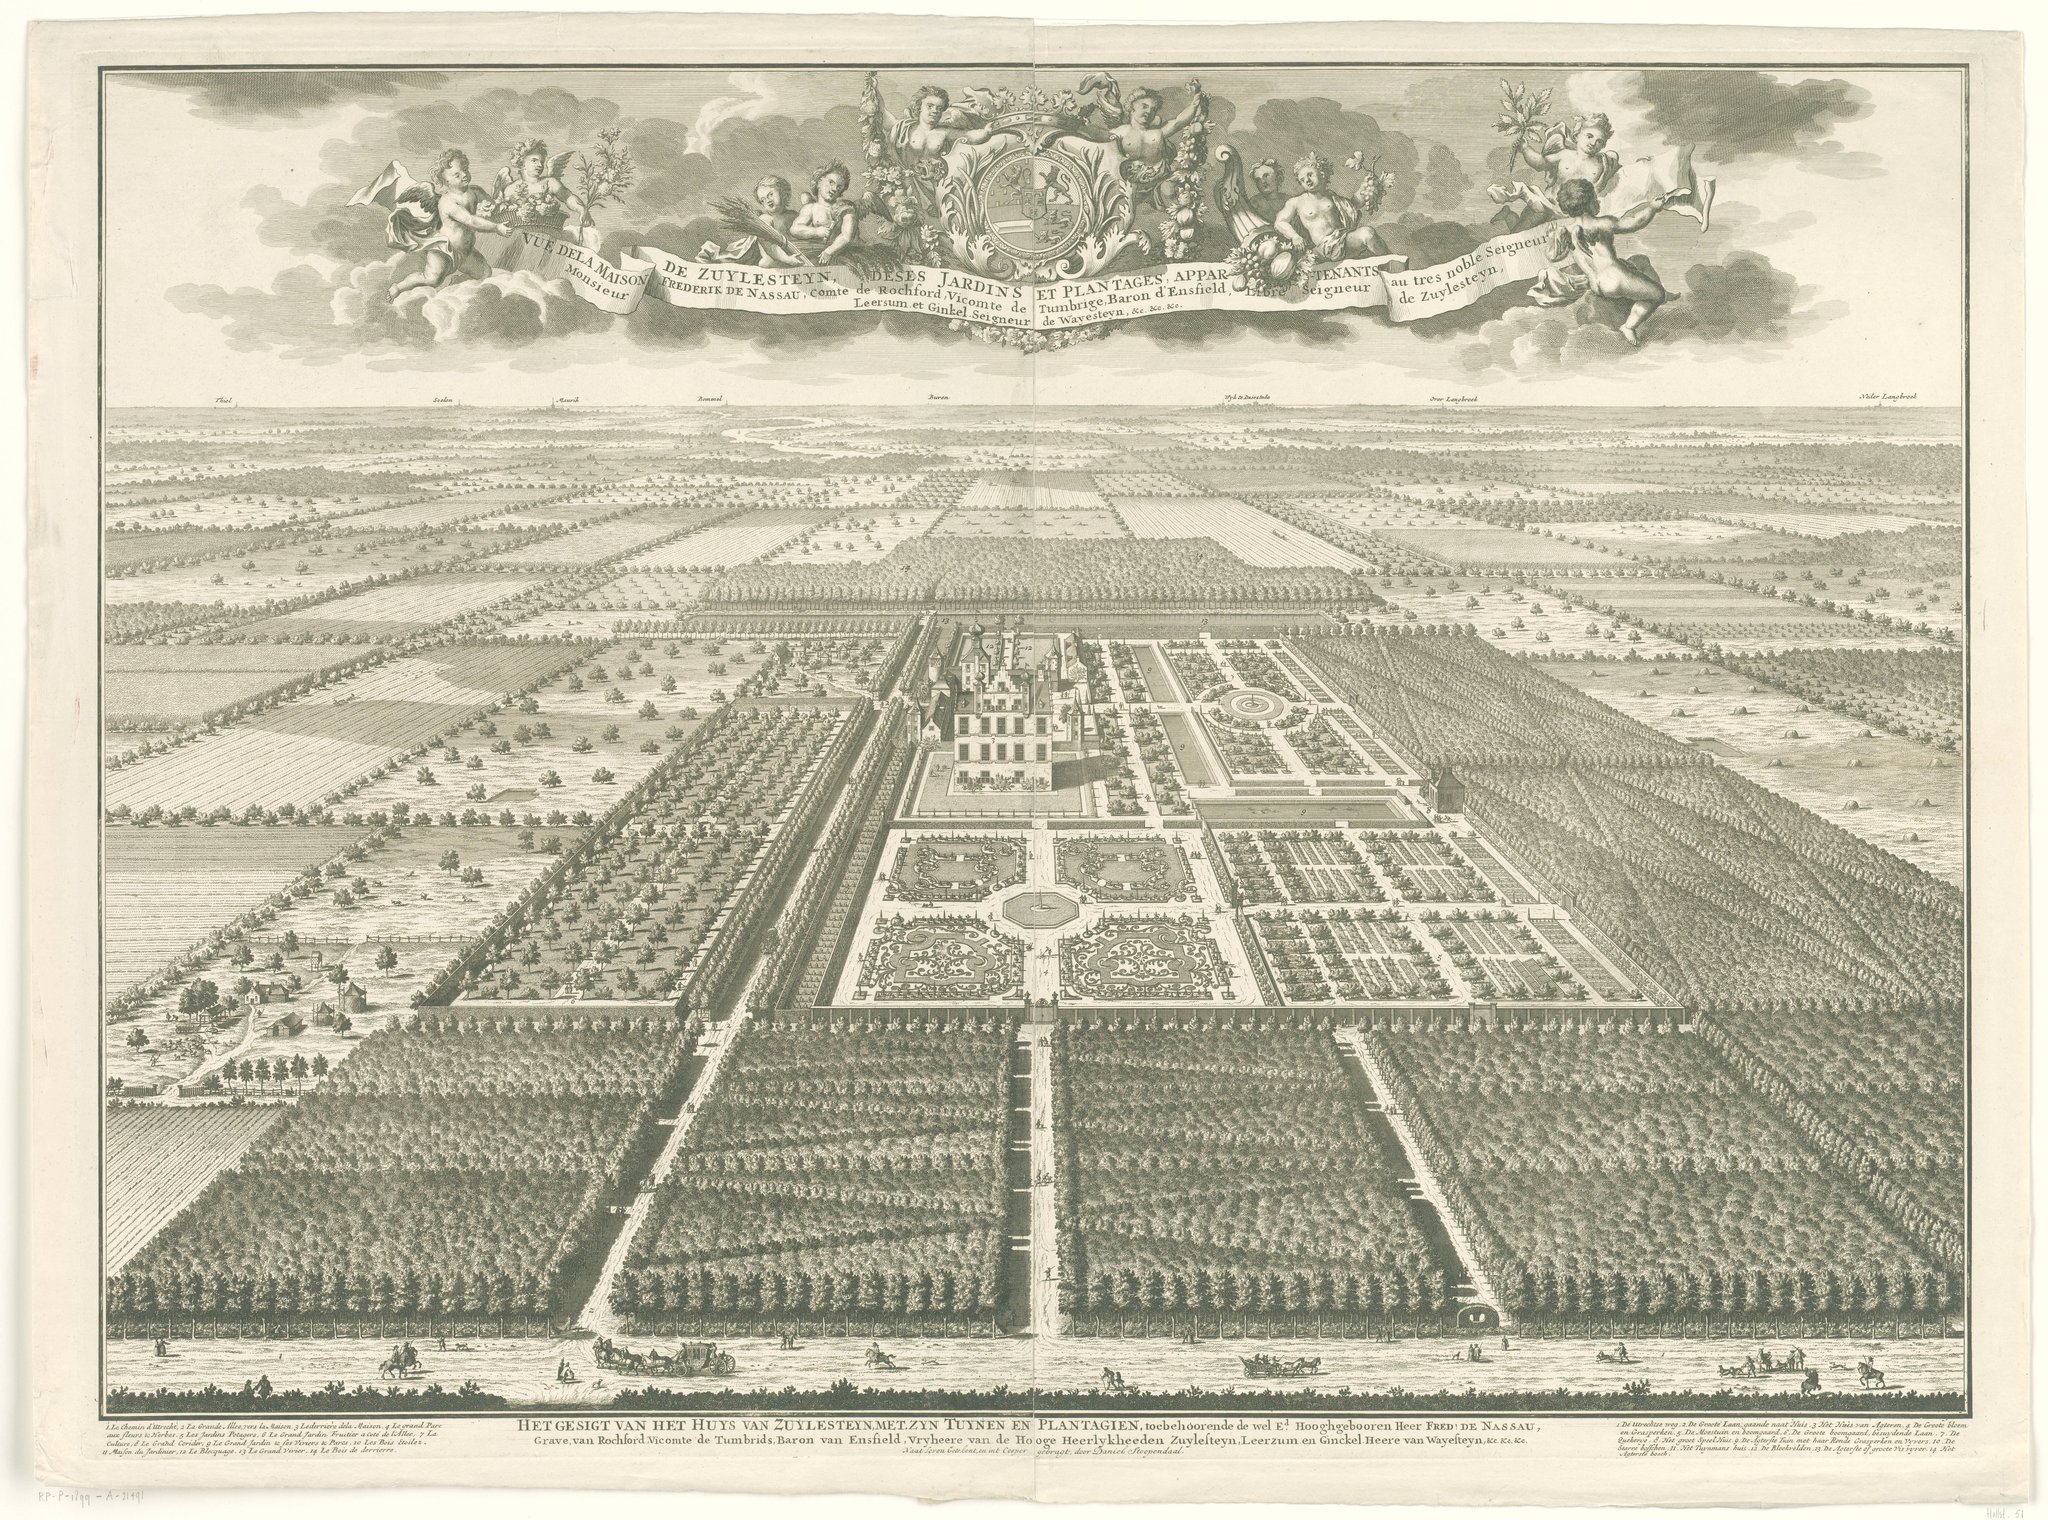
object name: print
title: Veue de la maison de Zuylestein, de ses Jardins et Plantages, appartenants monsieur (...) / Het Gesigt van het Huys van Zuylestein, met zyn tuynen en plantagien, toebehoorende de Wel Ed. Hooghgebooren Heer Fred de Nassau, Grave van Rochford, Vicomte de Tumbrids (...)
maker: daniël stopendaal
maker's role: print maker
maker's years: 1672-1726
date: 1710-1726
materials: paper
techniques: etching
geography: amsterdam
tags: london, earl, french or architectonic garden; formal garden, bird's eye view ~ representation of building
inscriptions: collector's mark: Lugt 2228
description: Gezicht op kasteel Zuilenstein te Leersum met de tuinen en de omgeving in vogelvlucht. Op de achtergrond in het landschap Tiel, Wijk bij Duurstede en Langbroek. In de lucht tonen putti een banderol en het stamwapen van Nassau-Zuylenstein. Onderaan in de marge een legenda in het Frans en in het Nederlands.